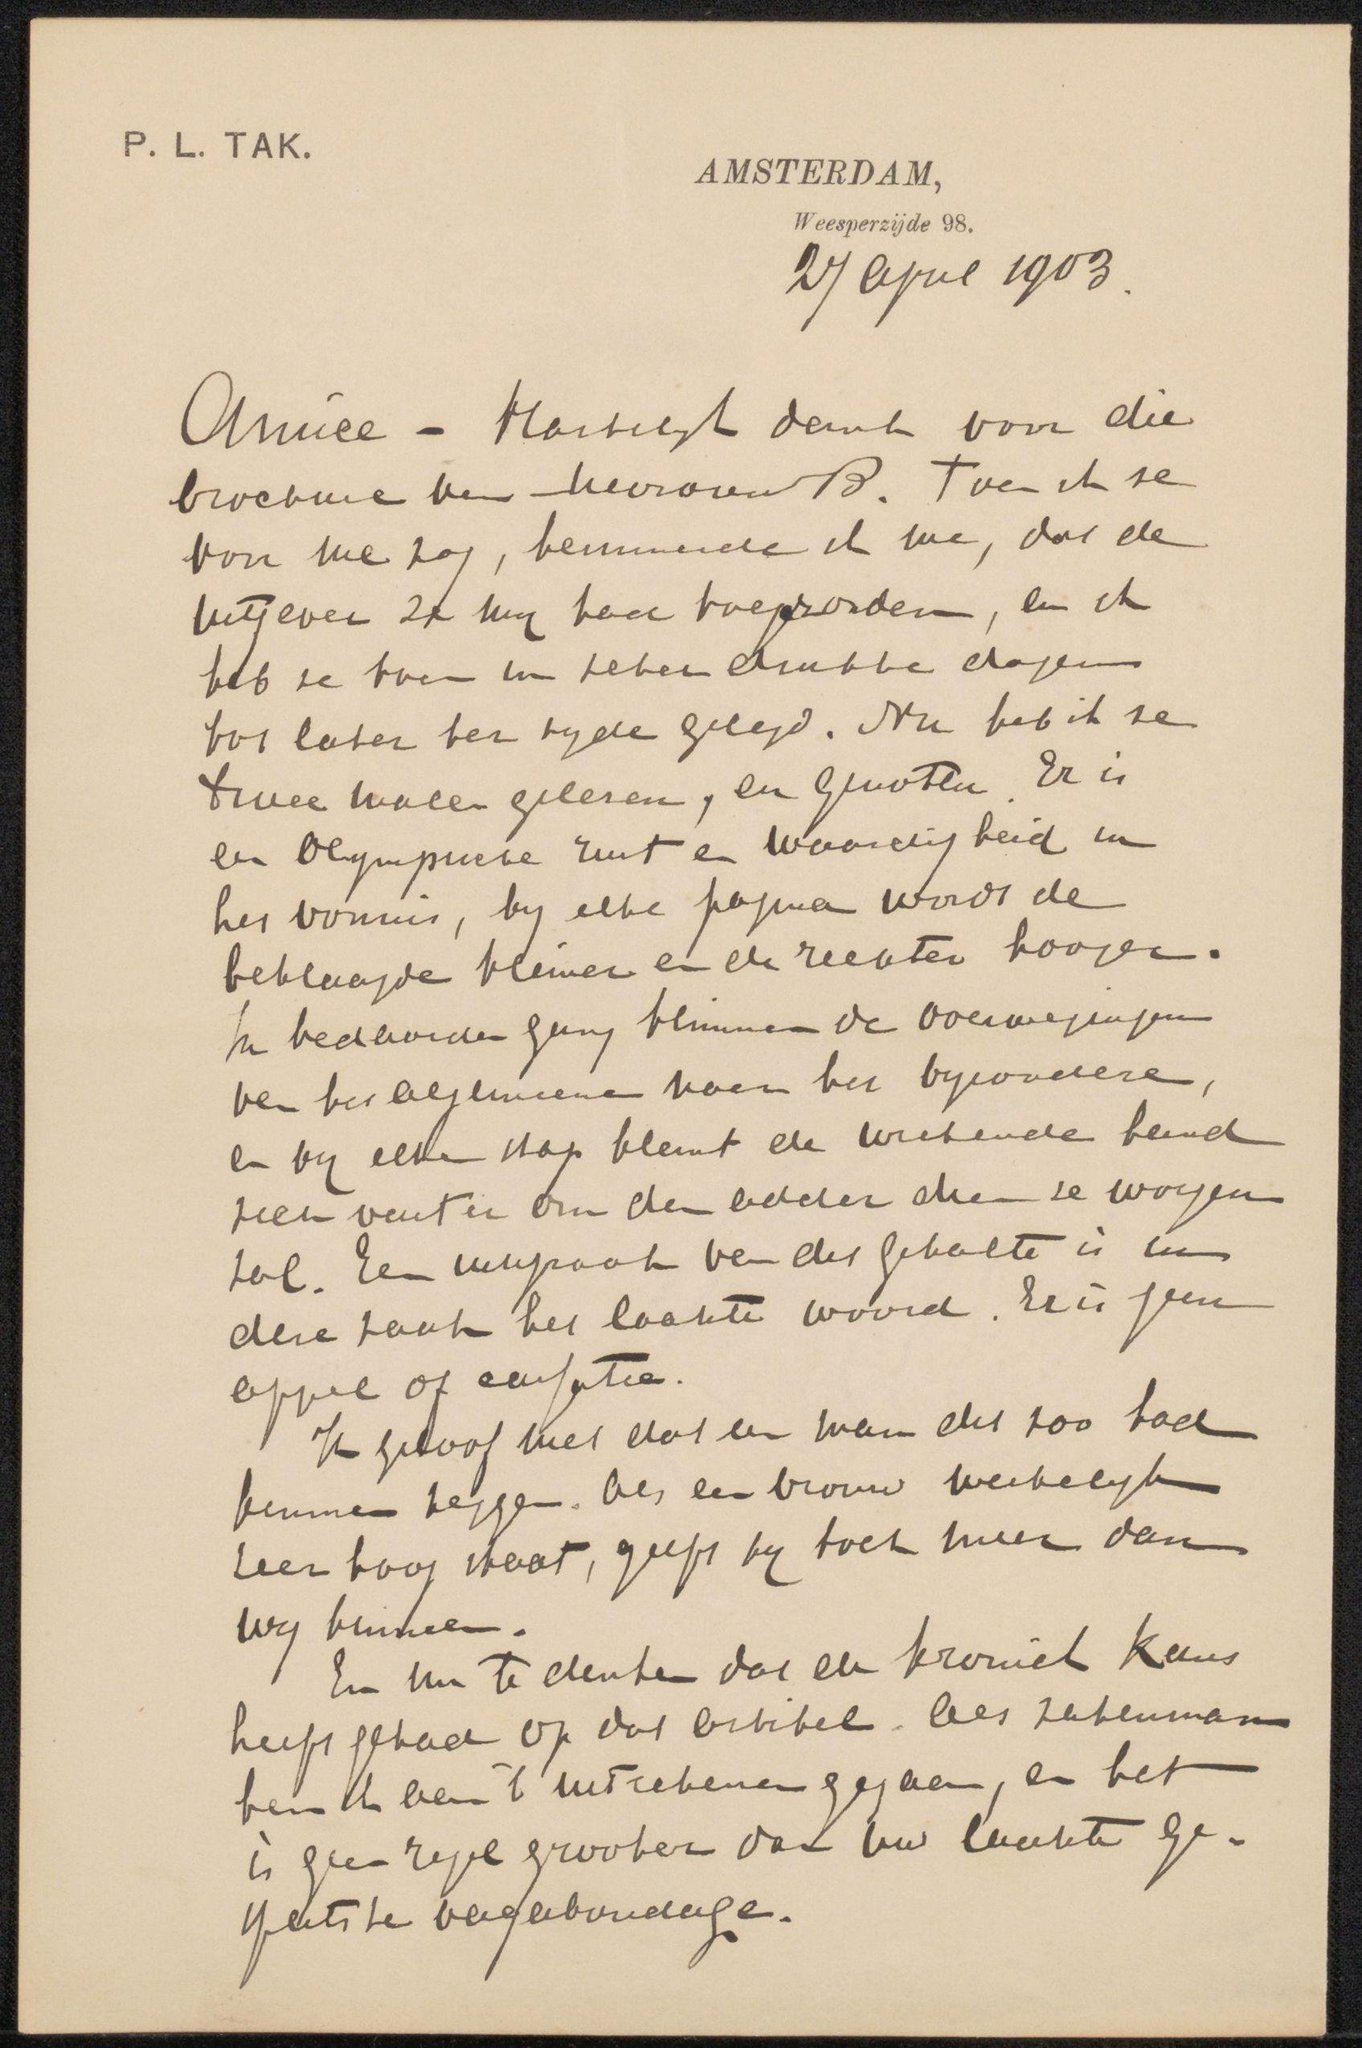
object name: letter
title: Brief aan Jan Veth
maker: pieter lodewijk tak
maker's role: politician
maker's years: 1848-1907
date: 1903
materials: ink, paper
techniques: pen, printing, writing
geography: amsterdam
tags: dordrecht, painter, print maker, draughtsman, designer, jan veth, andré jolles, printed matter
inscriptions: collector's mark: ‘RPK’, watermark